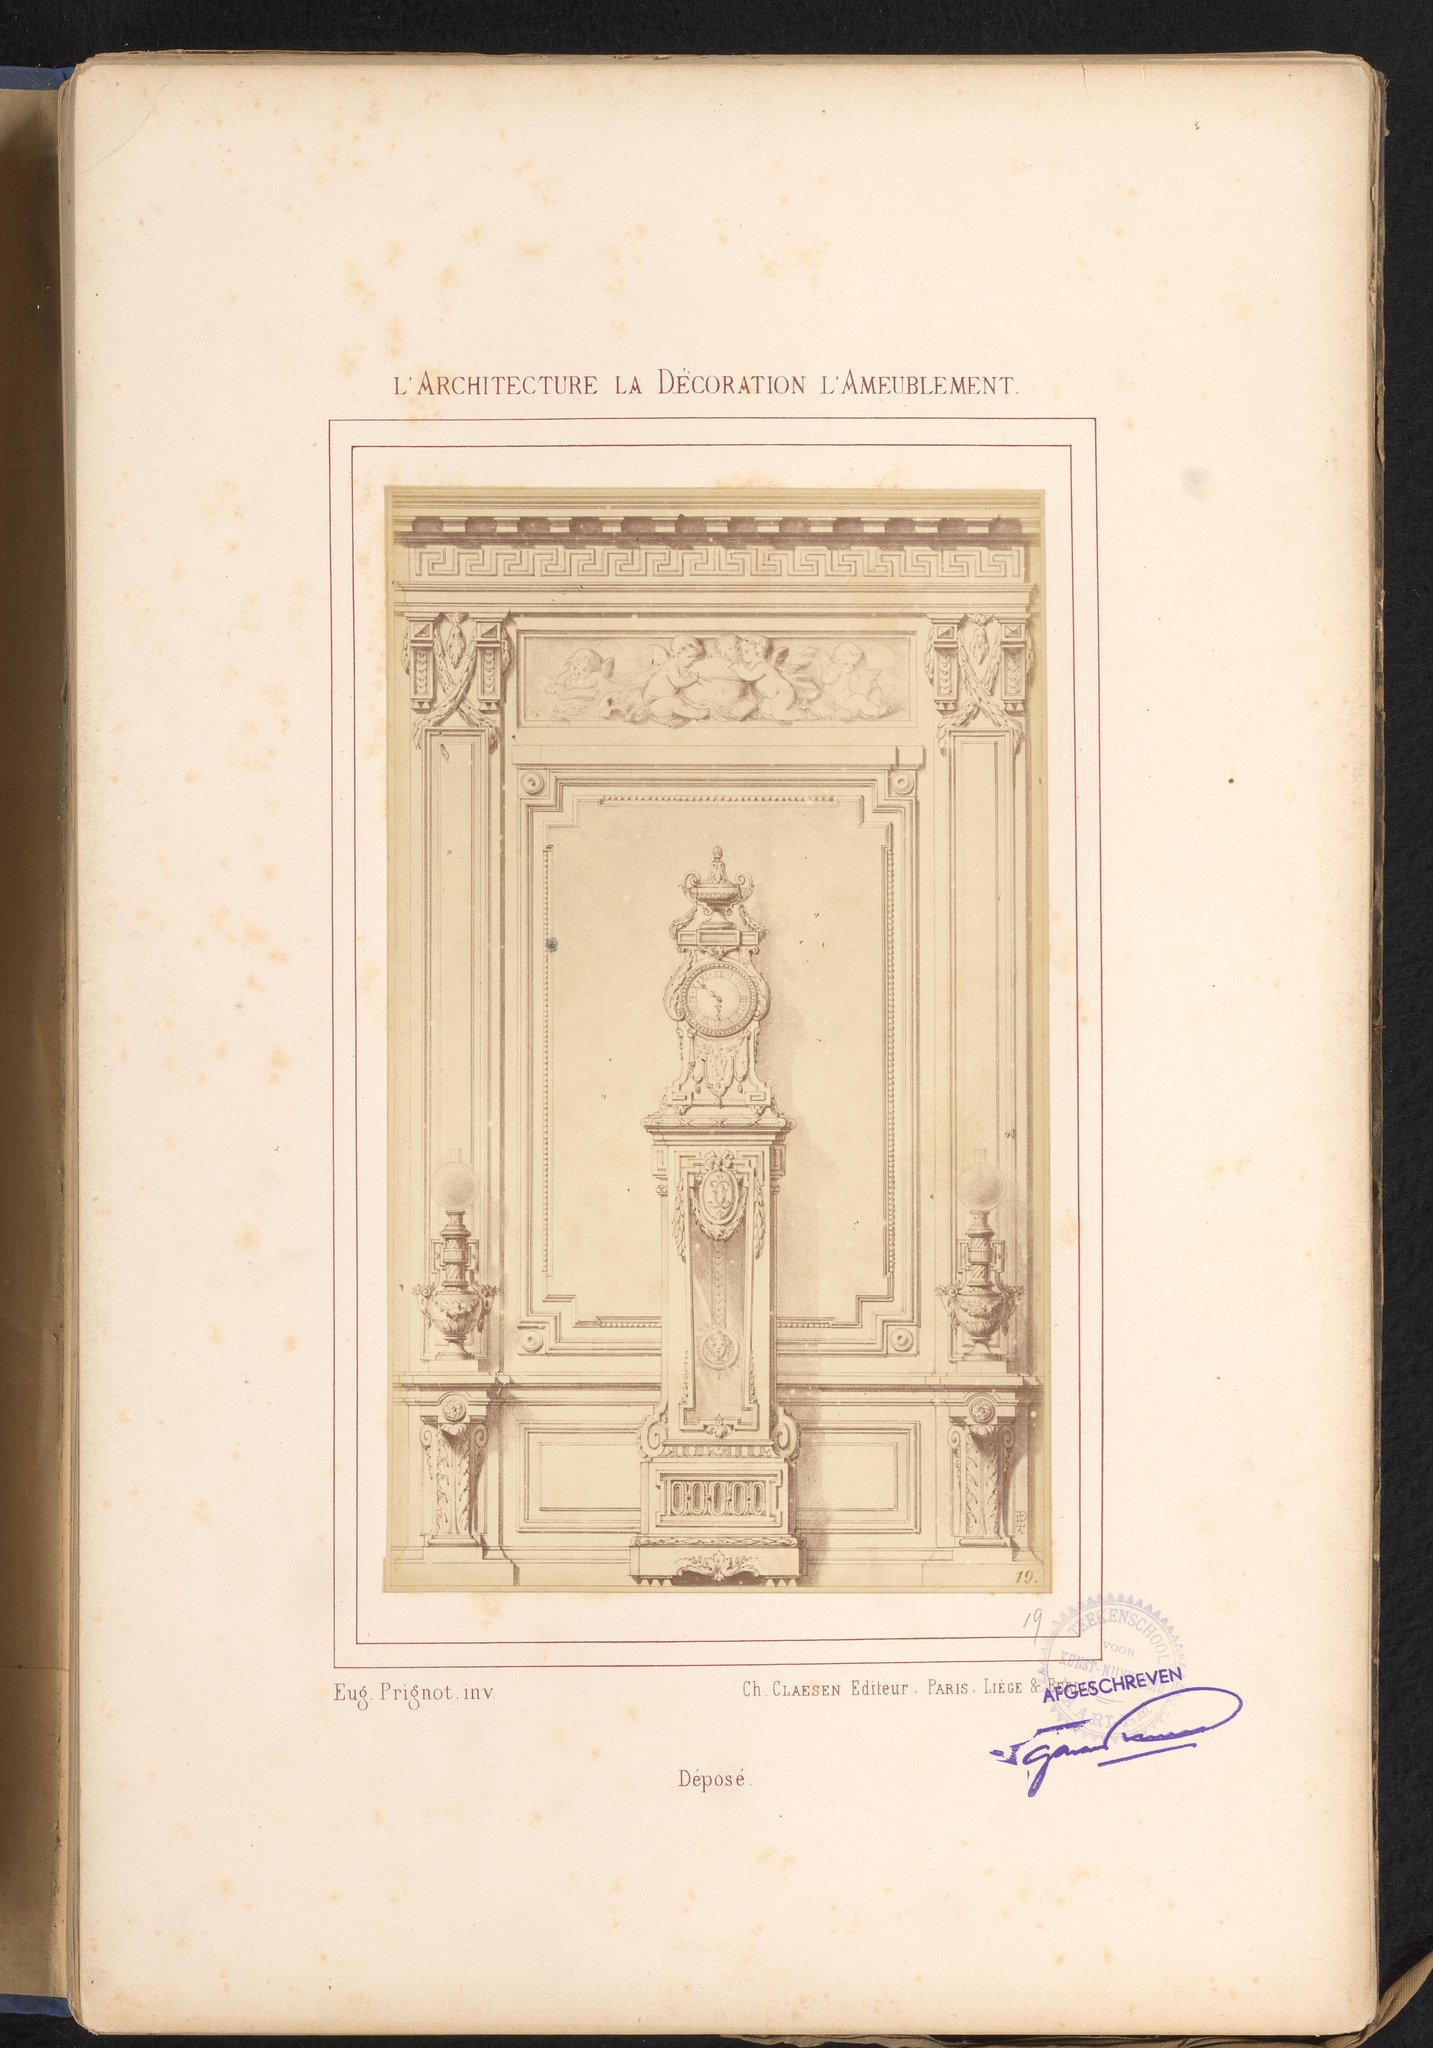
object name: photograph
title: L'Architecture la Décoration l'Ameublement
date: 1873-1880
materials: cardboard, paper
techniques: albumen print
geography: liège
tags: clock, wall-covering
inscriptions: stamp: ‘TEEKENSCHOOL/ VOOR/ KUNST-NIJVERHEID/ HAARLEM’, inscription: ‘Déposé’, inscription: ‘Eug. Prignot. inv.’, stamp: ‘AFGESCHREVEN/ [...]’, number: ‘19’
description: Deze foto maakt deel uit van een omslag met 61 foto's op 61 bladen.